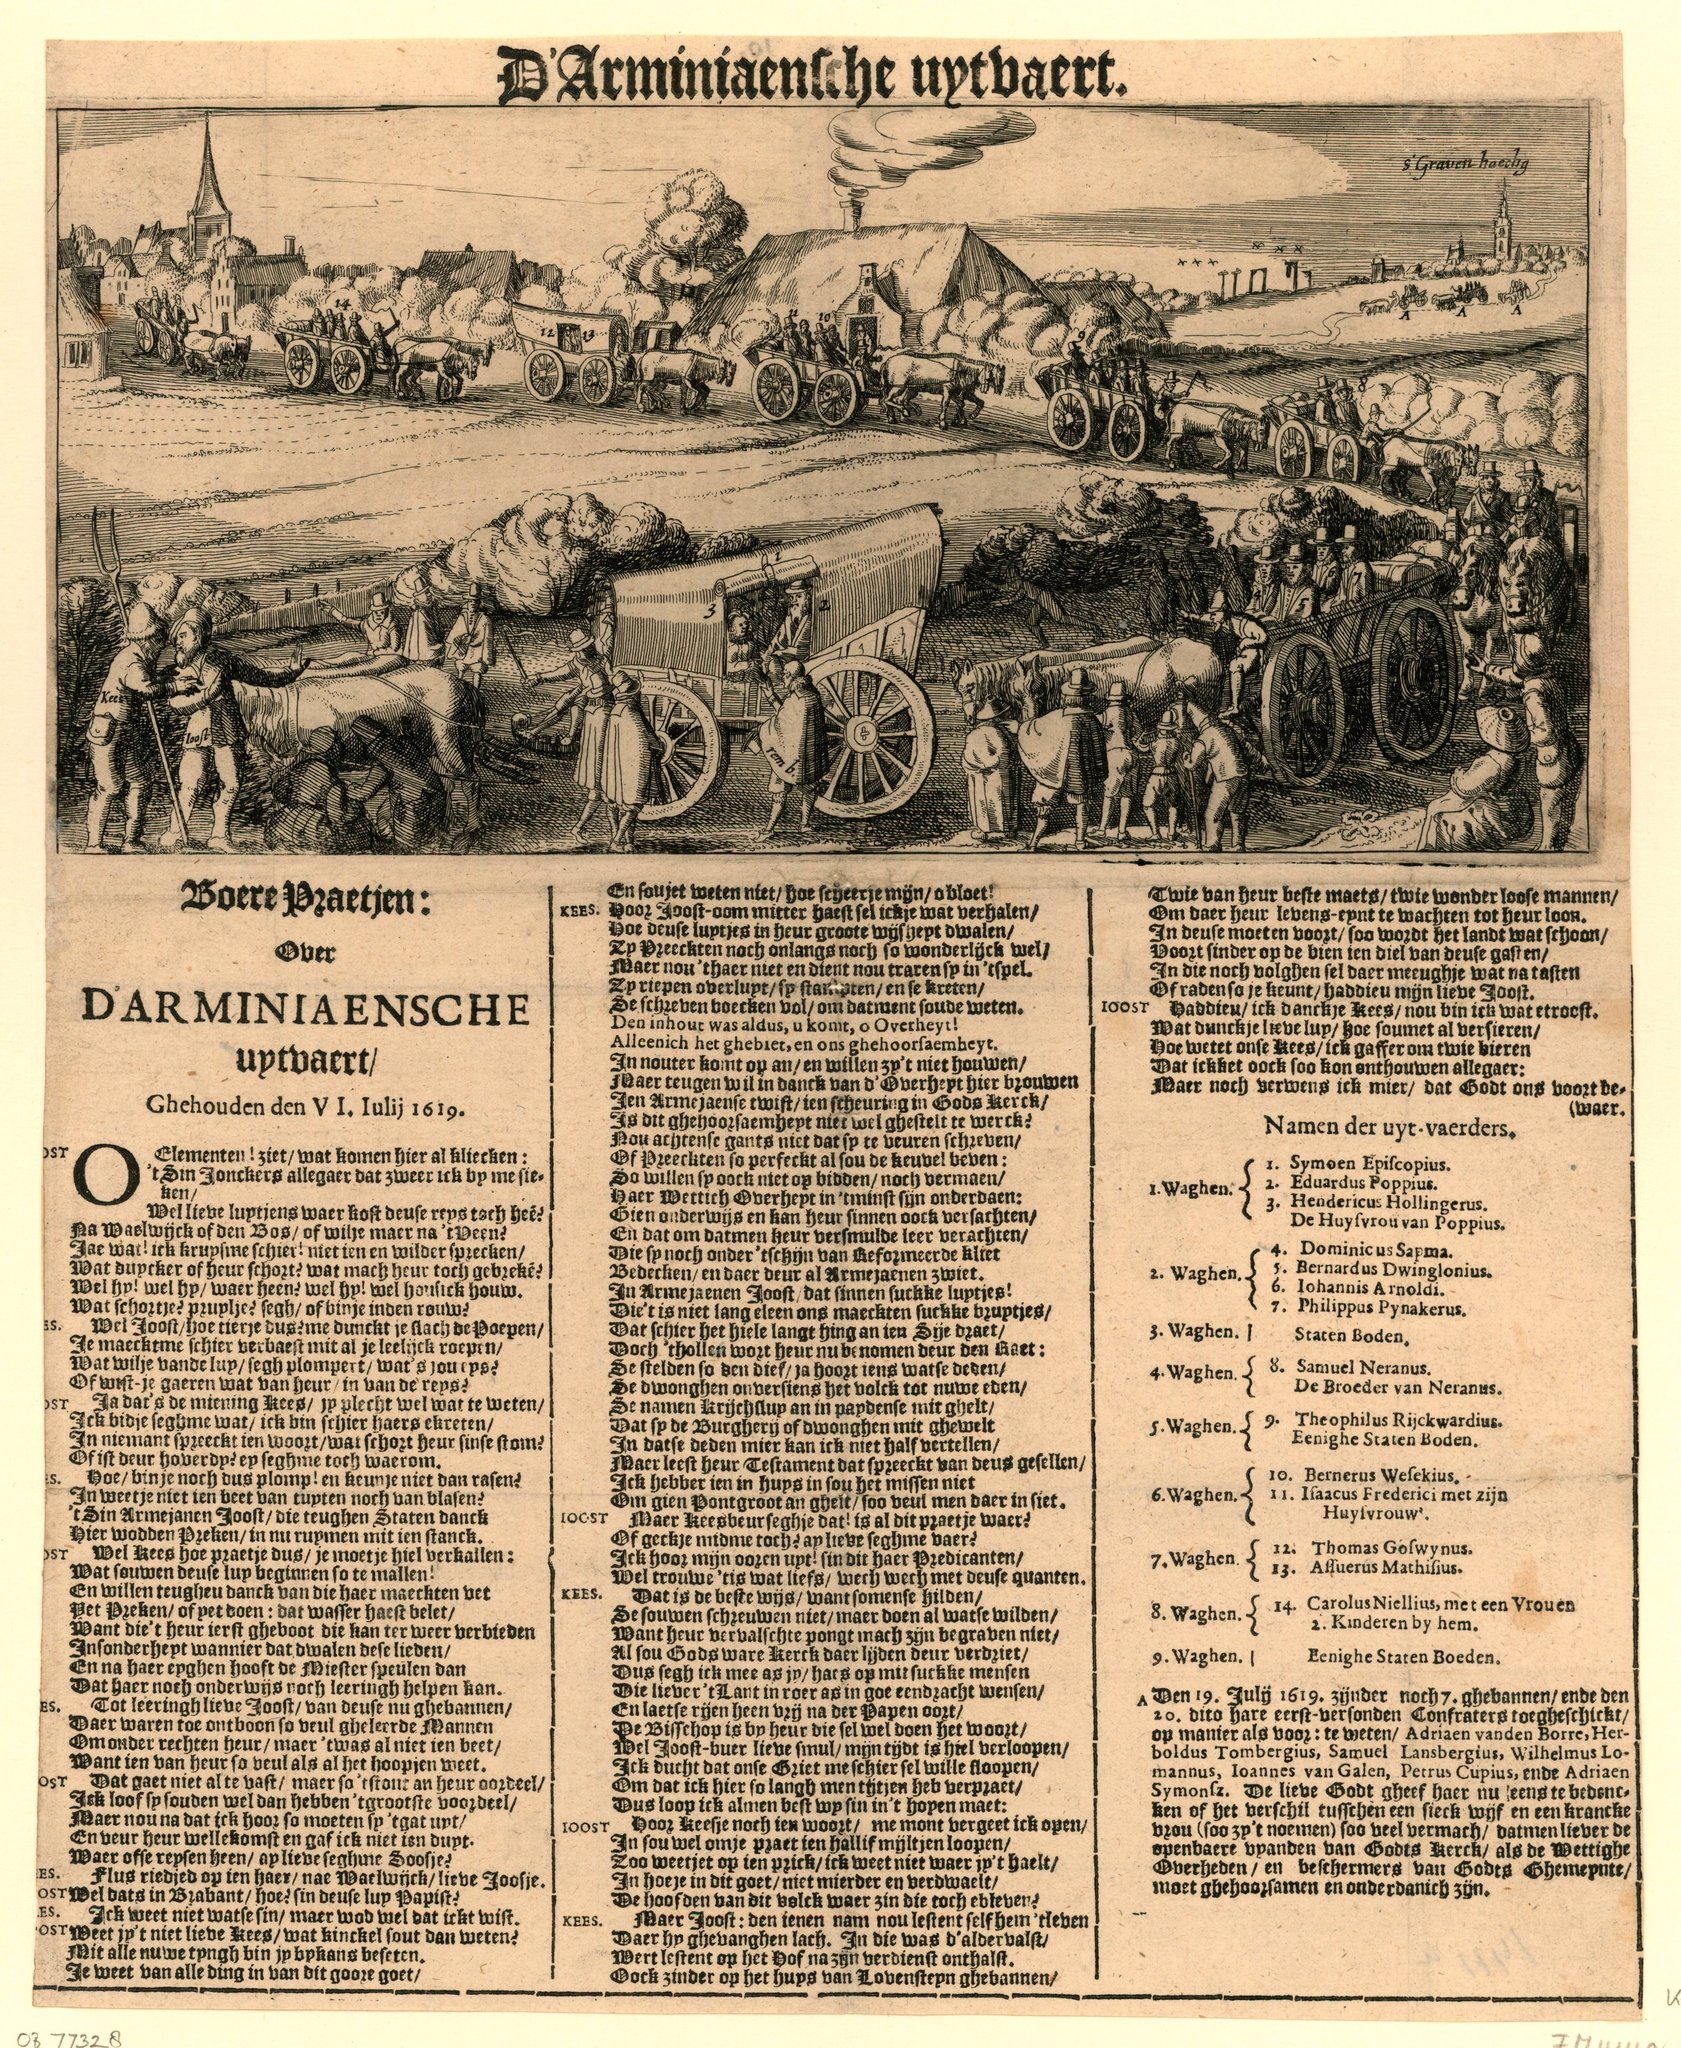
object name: print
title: D'Arminiaensche uytvaert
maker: Anonymous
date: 1619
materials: paper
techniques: etching, letterpress printing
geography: northern netherlands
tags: banishment, exile, the hague, waalwijk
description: Spotprent op de uittocht van de remonstranten uit 's-Gravenhage op 6 juli 1619 na de veroordeling door de Synode. Onder de prent de samenspraak tussen twee boeren genaamd Kees en Joost getiteld 'Boere Praetjen: over D'Arminiaensche uytvaert / Ghehouden den VI. Iulij 1619'. Rechts een lijst van de wagens met de namen van de passagiers.